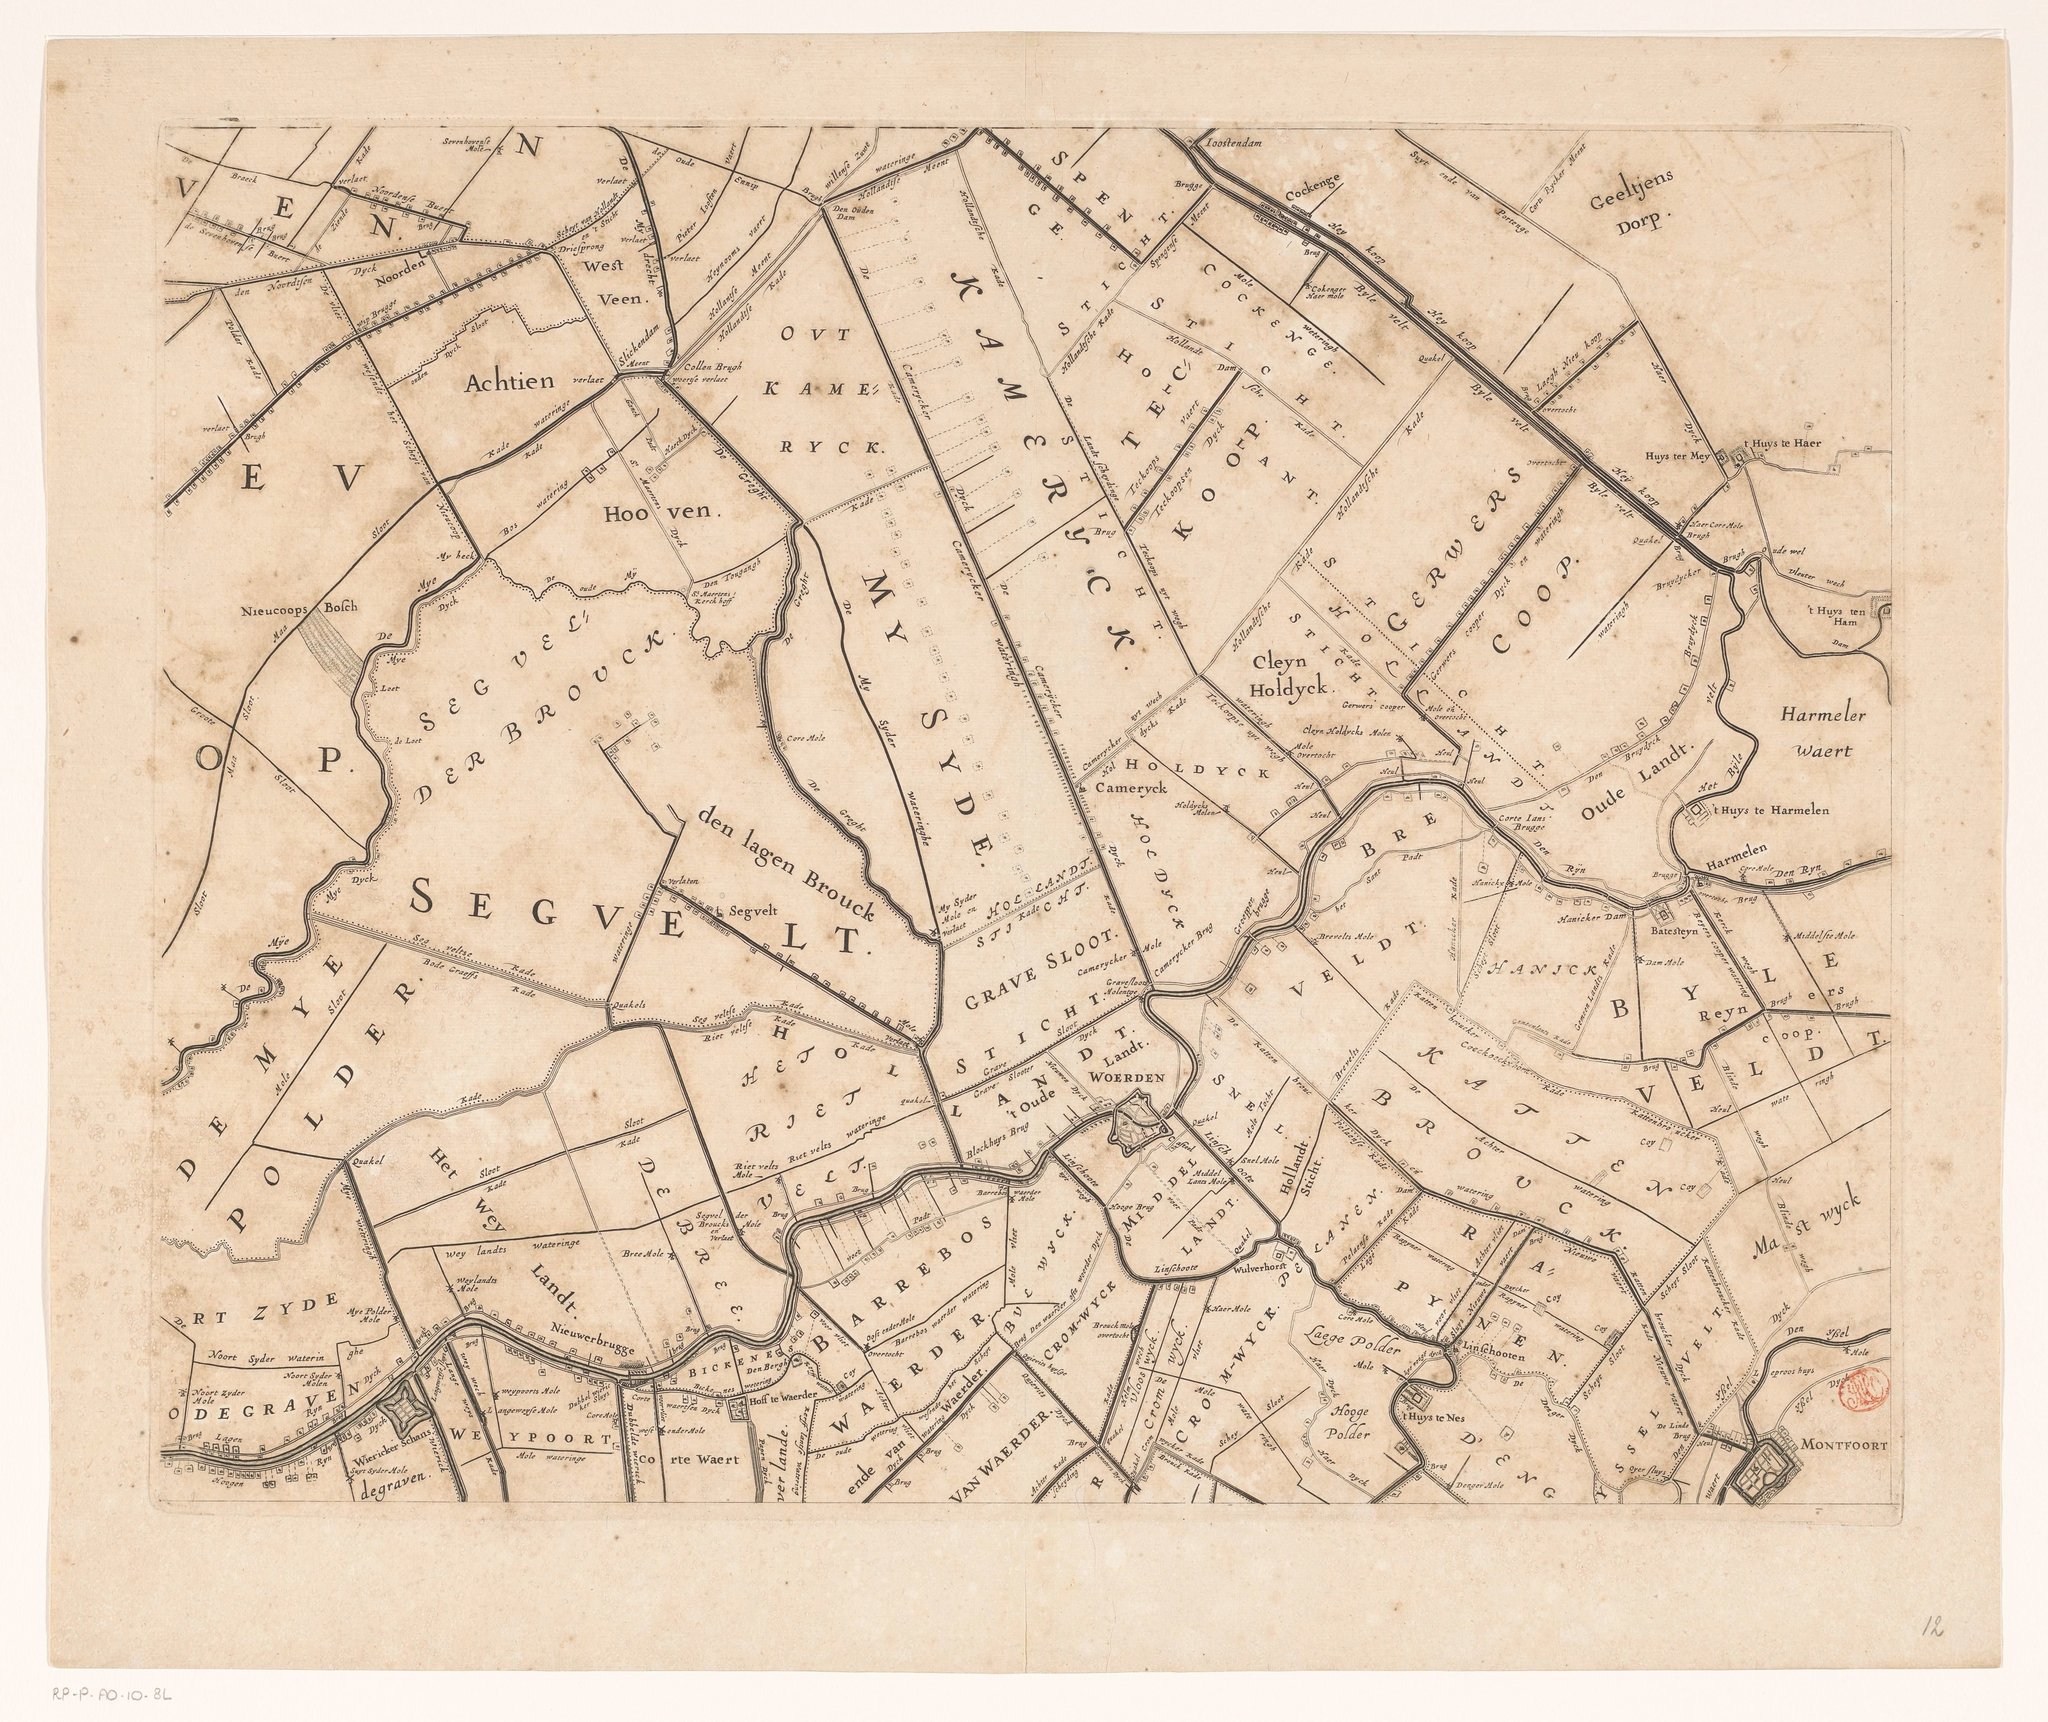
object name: map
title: T' Hoogheymraedschap van Rhynland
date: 1647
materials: paper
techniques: engraving, etching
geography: amsterdam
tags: maps of separate countries or regions, polder, reclaimed land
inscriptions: collector's mark: Lugt 195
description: Deze prent behoort tot de tweede druk (1687) van 'T' Hoogheymraedschap van Rhynland', een wandkaart van het Hoogheemraadschap van Rijnland bestaande uit een kaart van het gebied en een sierrand. Van deze kaart zijn voor zover na te gaan drie verschillende drukken bekend, uit respectievelijk 1647, 1687 en 1746. Het kaartdeel is gedrukt van twaalf platen die voor elke druk zijn aangepast. Het vijfde blad van het kaartdeel (RP-P-AO-10-8H) is in of na 1766 nog een keer bijgewerkt en los uitgegeven. Hierdoor zijn van het vijfde blad vier staten bekend en van de overige bladen drie. Zie documentatie voor meer informatie. Bij de eerste en tweede druk hoort een sierrand met daarop de titel, wapenschilden en octrooiverleningen. Delen van de zijkant van de rand van de eerste druk zijn voor de tweede druk herbruikt, terwijl andere delen van de zijkanten en de hele bovenkant nieuw zijn gemaakt door Romeyn de Hooghe. De derde druk heeft slechts een nieuw gemaakte titelstrook langs de bovenkant.